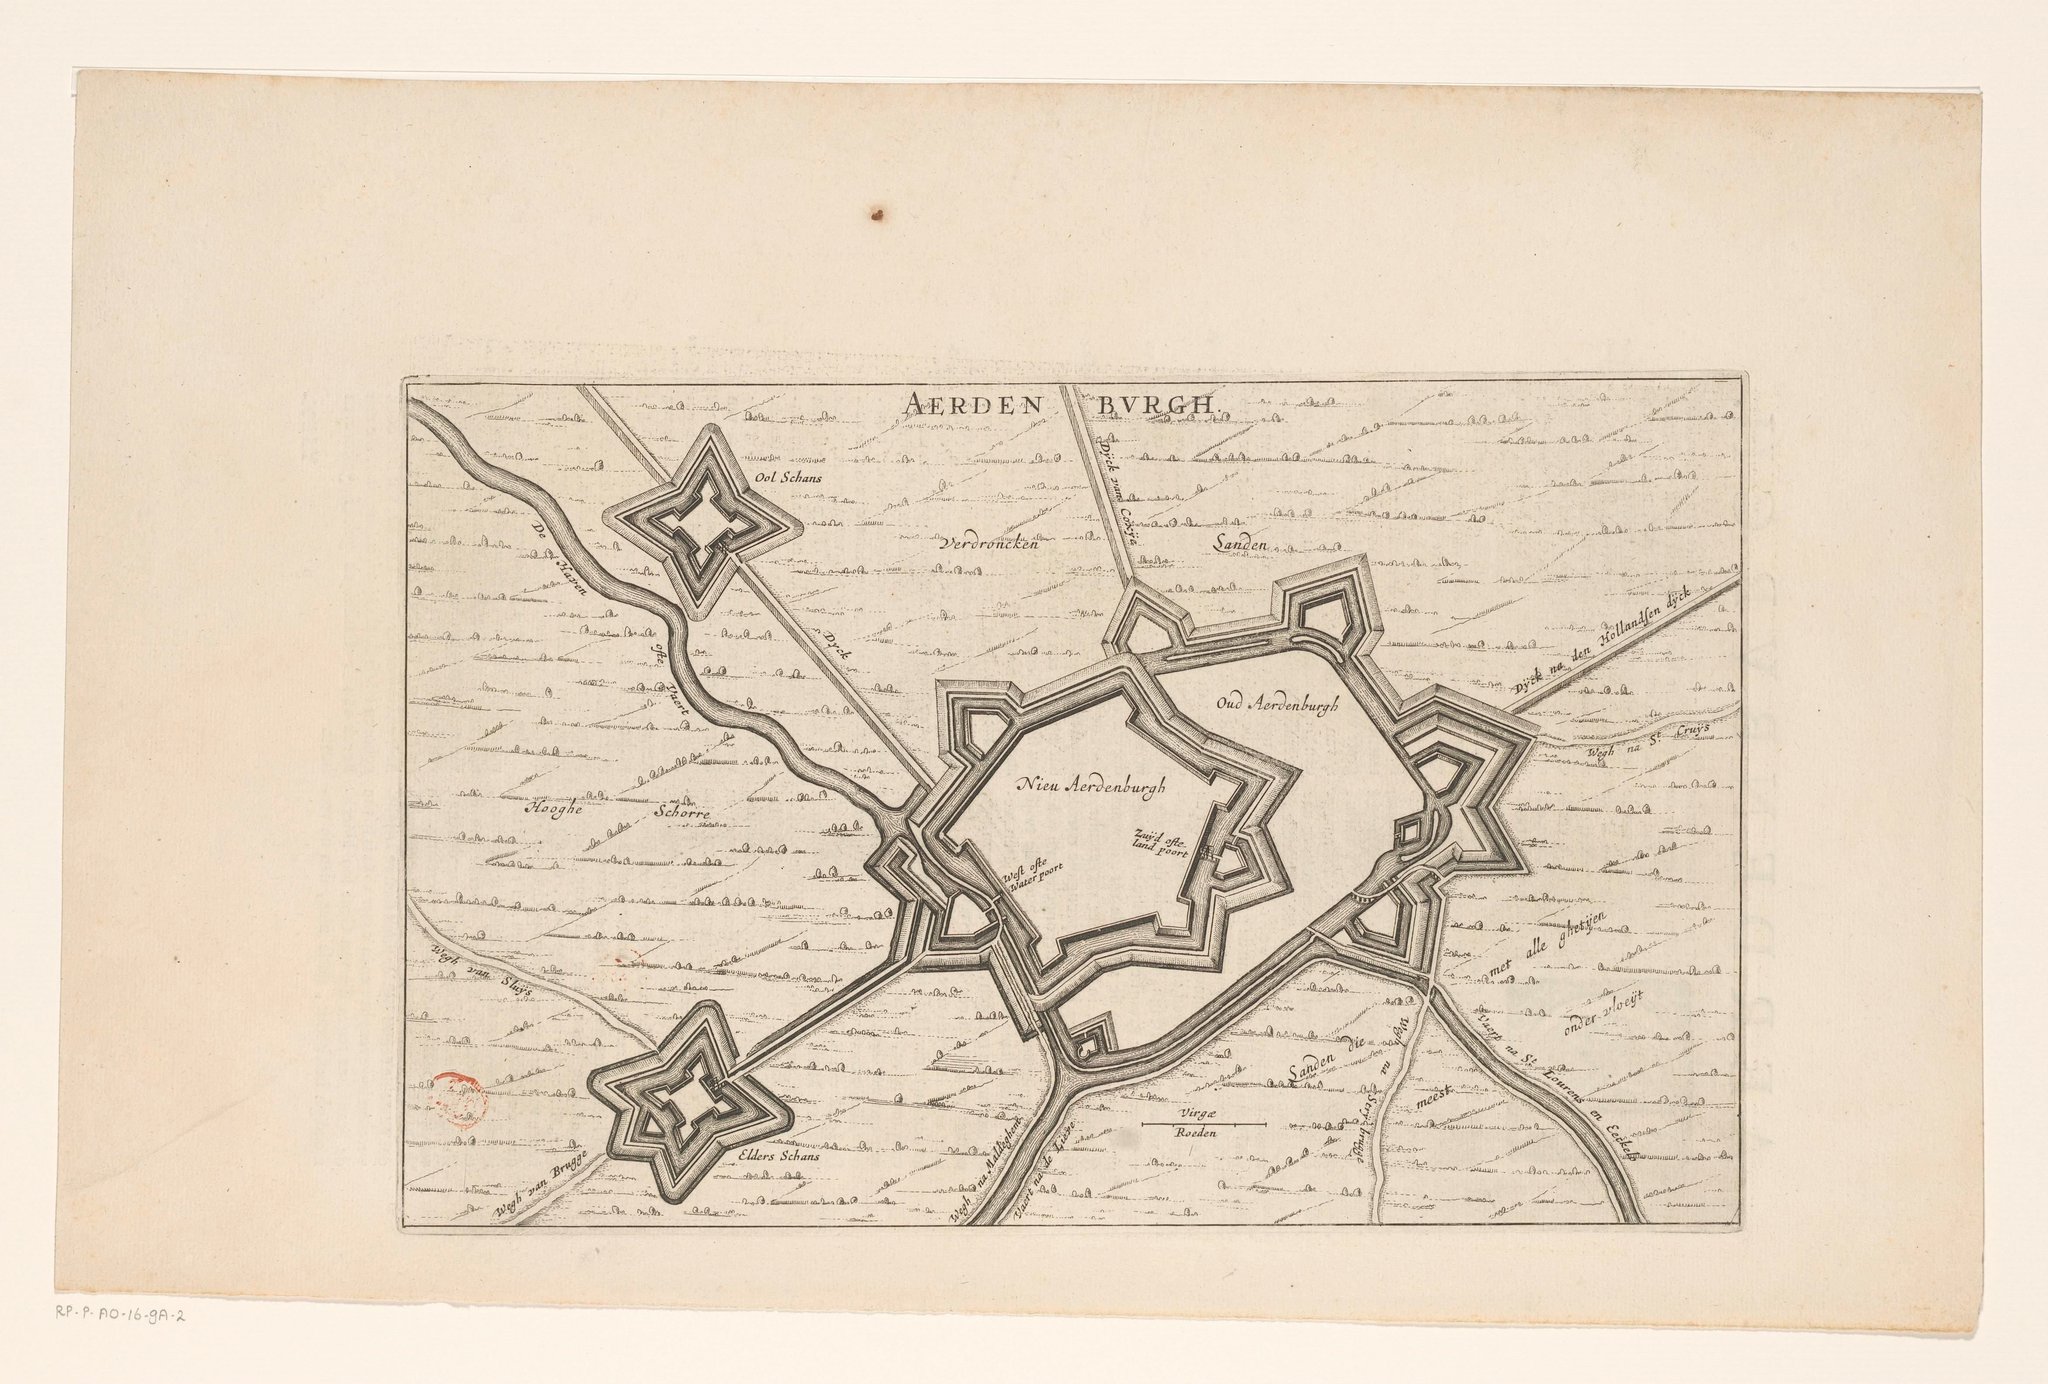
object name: area plan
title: Vestingplattegrond van Aardenburg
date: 1652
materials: paper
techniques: engraving, etching, letterpress printing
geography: amsterdam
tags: fortified city, maps of cities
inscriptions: collector's mark: Lugt 195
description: Prent gebruikt in: Blaeu, Johannes Willemszoon. Toonneel der steden van de Vereenighde Nederlanden. 2 delen. Amsterdam: Johannes Willemszoon Blaeu, 1652, dl. 1.